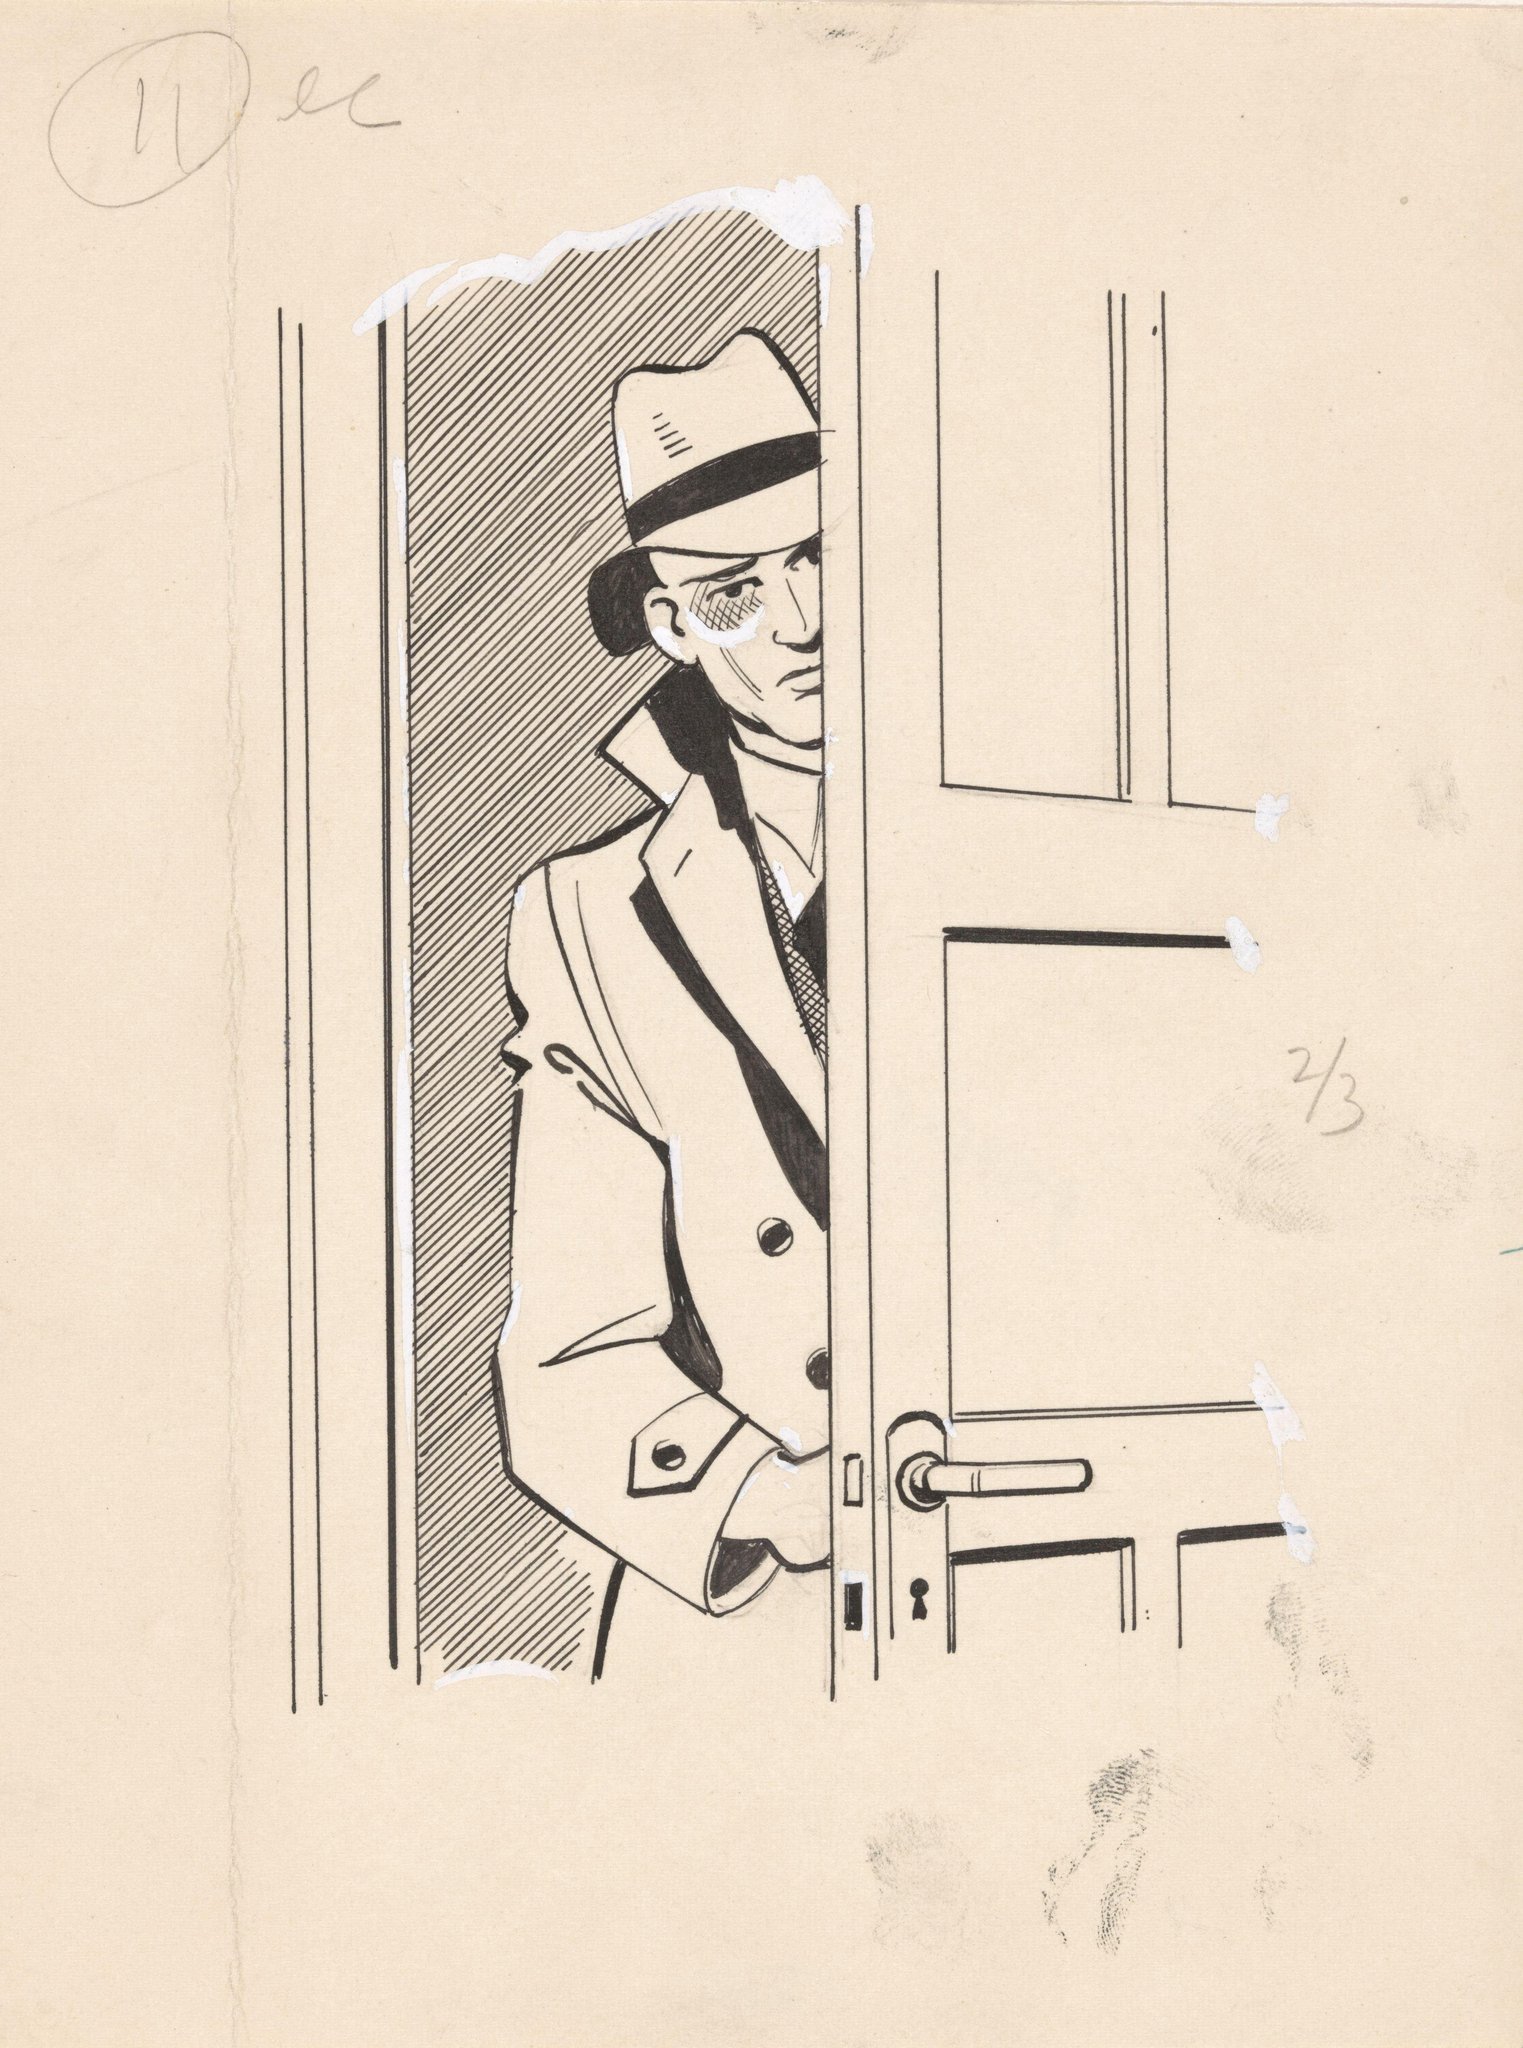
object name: boekillustratie ontwerp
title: Man kijkt langs een halfopen deur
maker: hans borrebach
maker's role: draughtsman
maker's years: 1903-1991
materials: paint, ink, paper, pencil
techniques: pen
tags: coat (+ men's clothes), head-gear: hat (+ men's clothes), opening the door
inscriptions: collector's mark: Lugt 2228a, :, annotation: ‘11 blz’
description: Een man in een lange jas met een hoed op staat in een deuropening met zijn hand op de deurklink. De deur is halfopen en hij kijkt langs de deur de ruimte binnen.